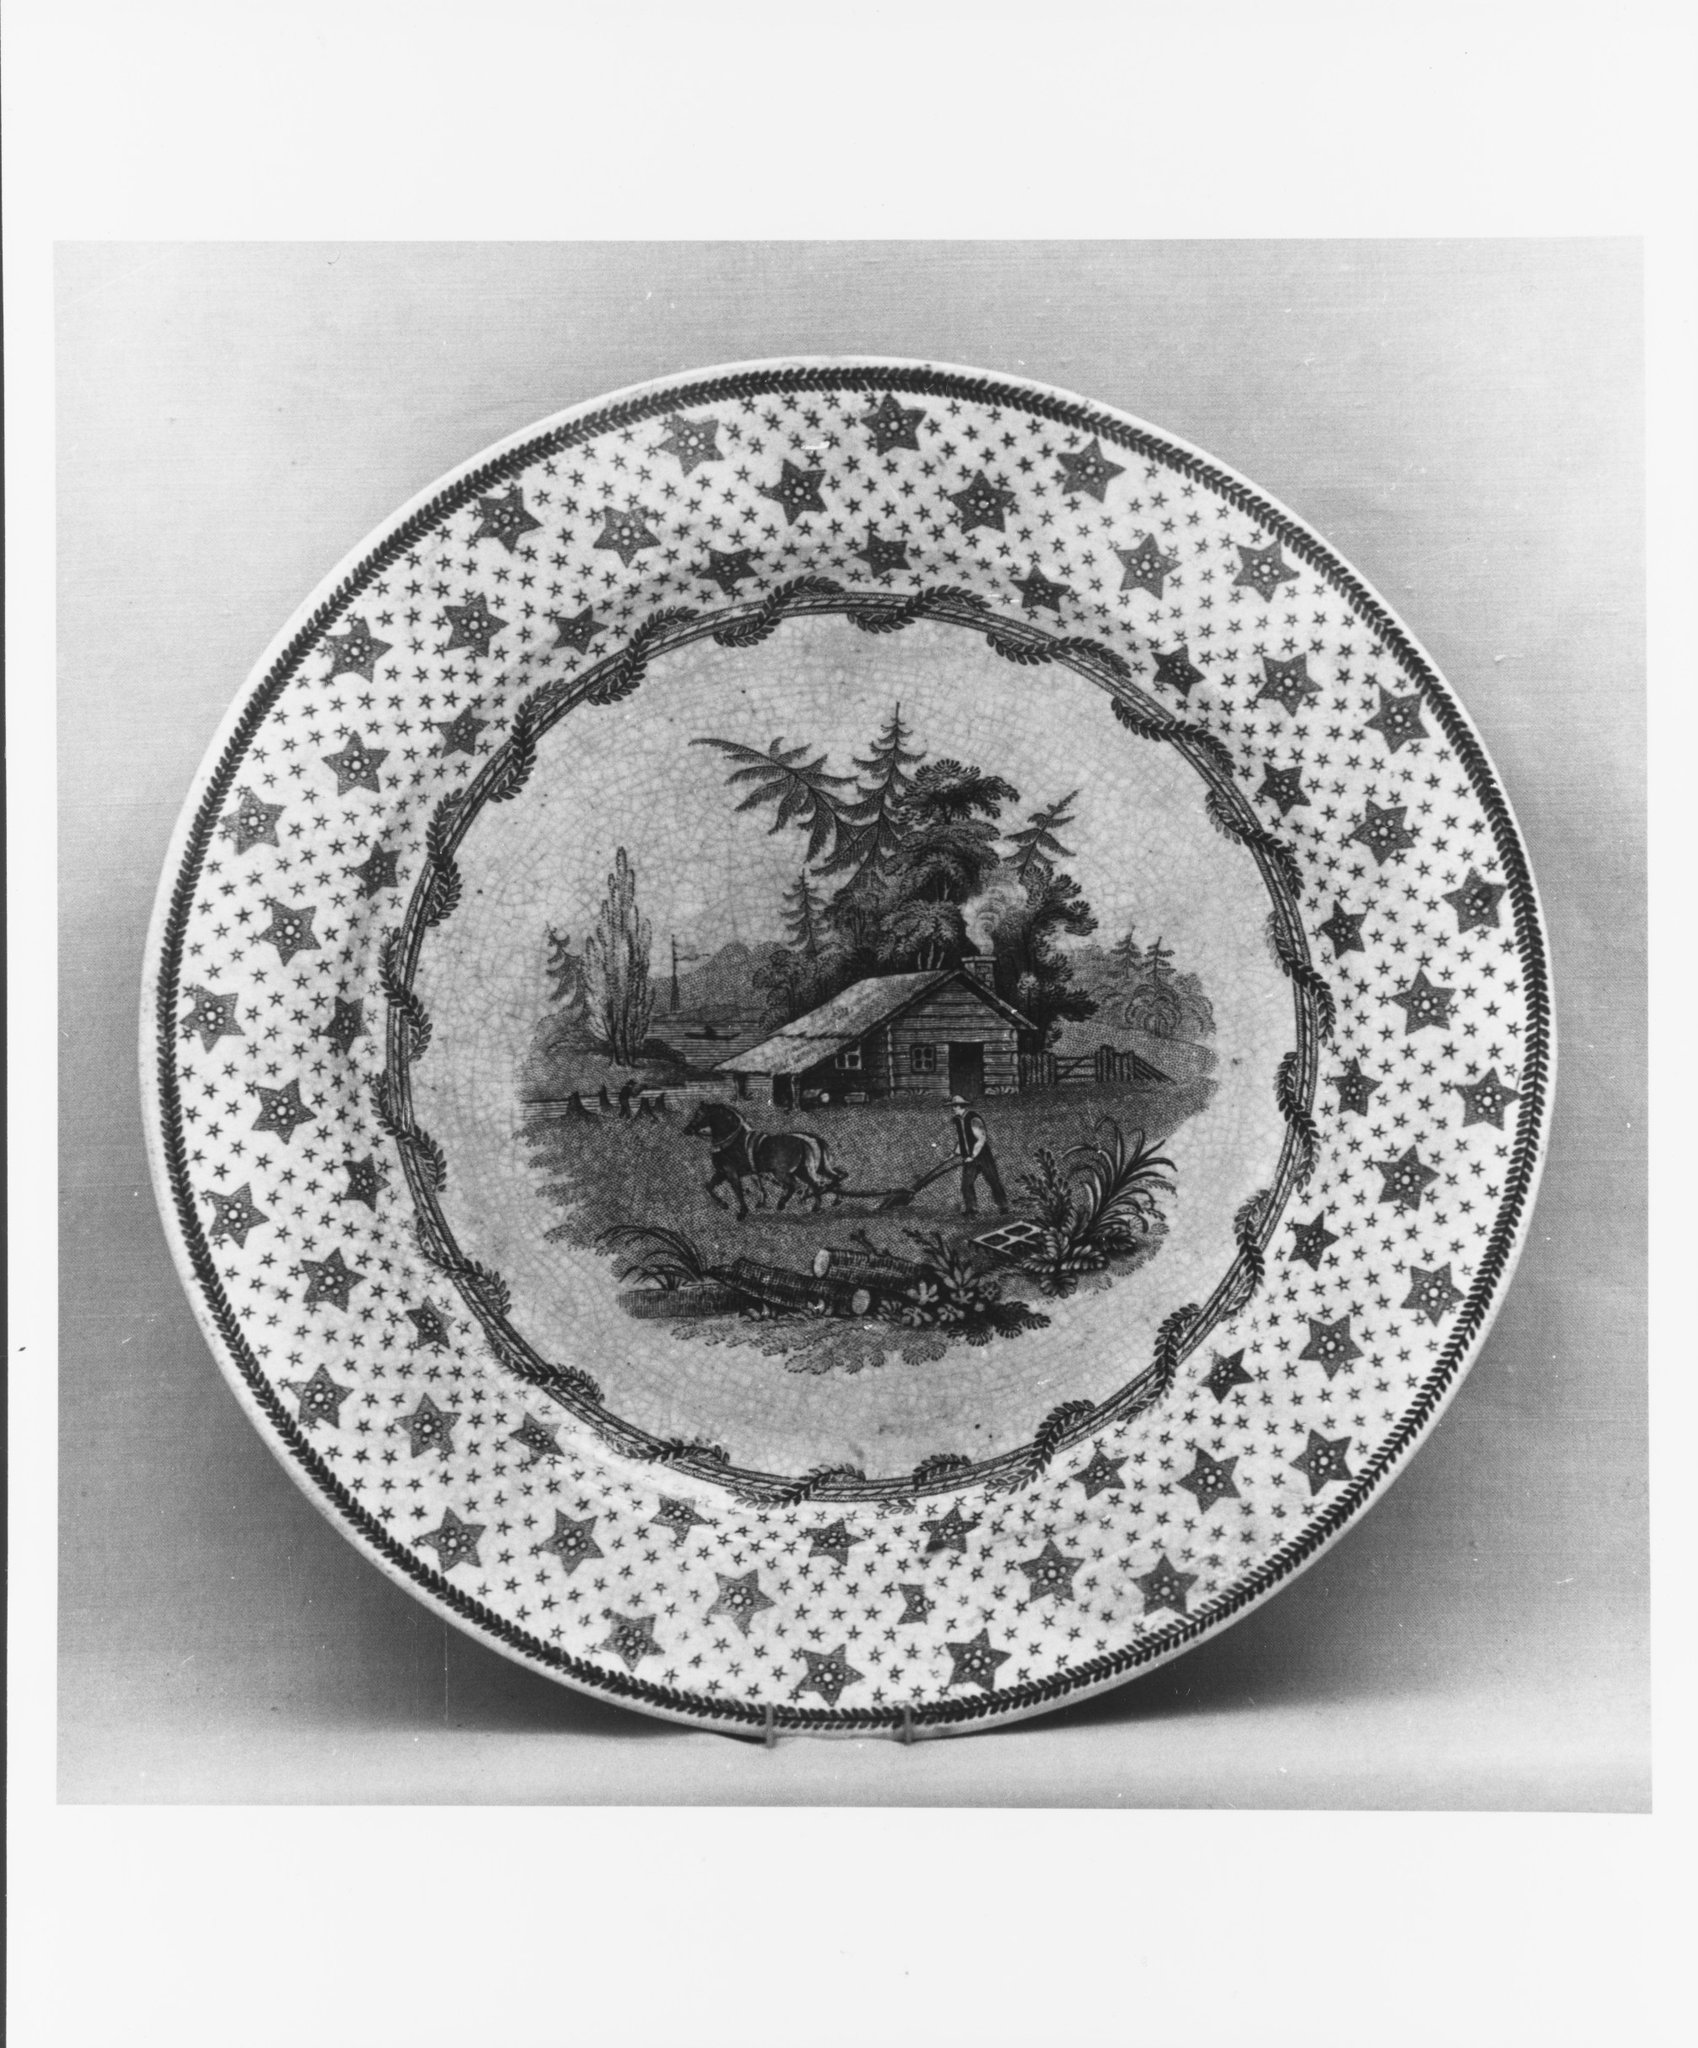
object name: plate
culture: british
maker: john ridgway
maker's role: maker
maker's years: 1827-1840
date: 1839-1840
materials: earthenware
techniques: transfer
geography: england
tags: houses,farmers